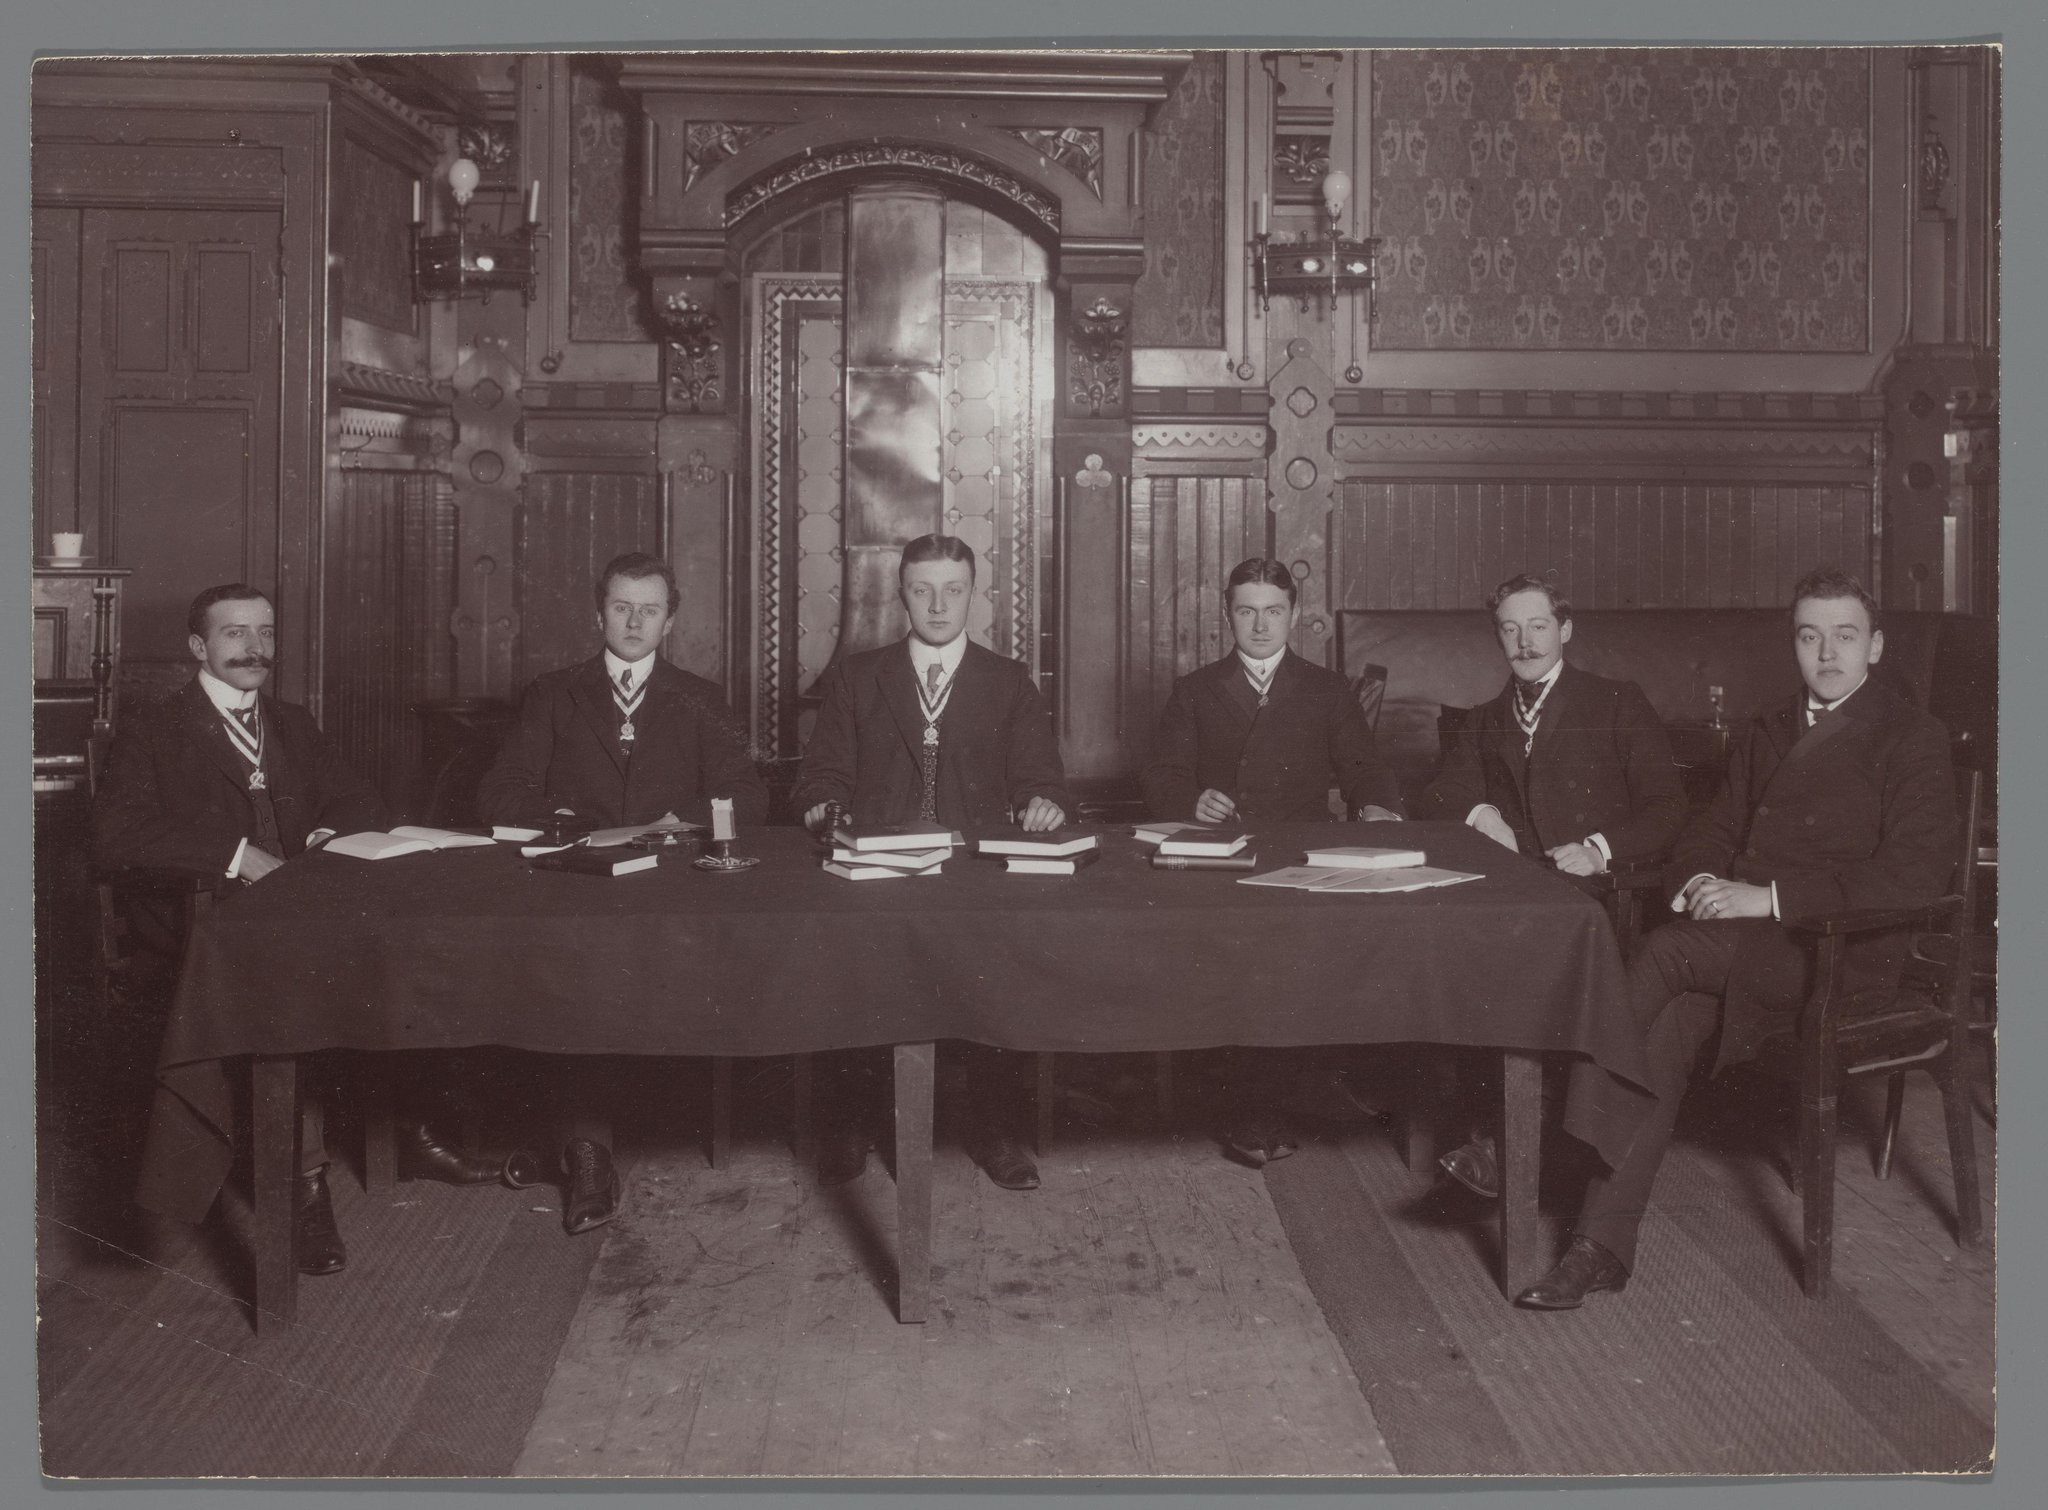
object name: photograph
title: Portret van zes mannen achter tafel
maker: Anonymous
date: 1907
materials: photographic support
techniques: collodion silver print